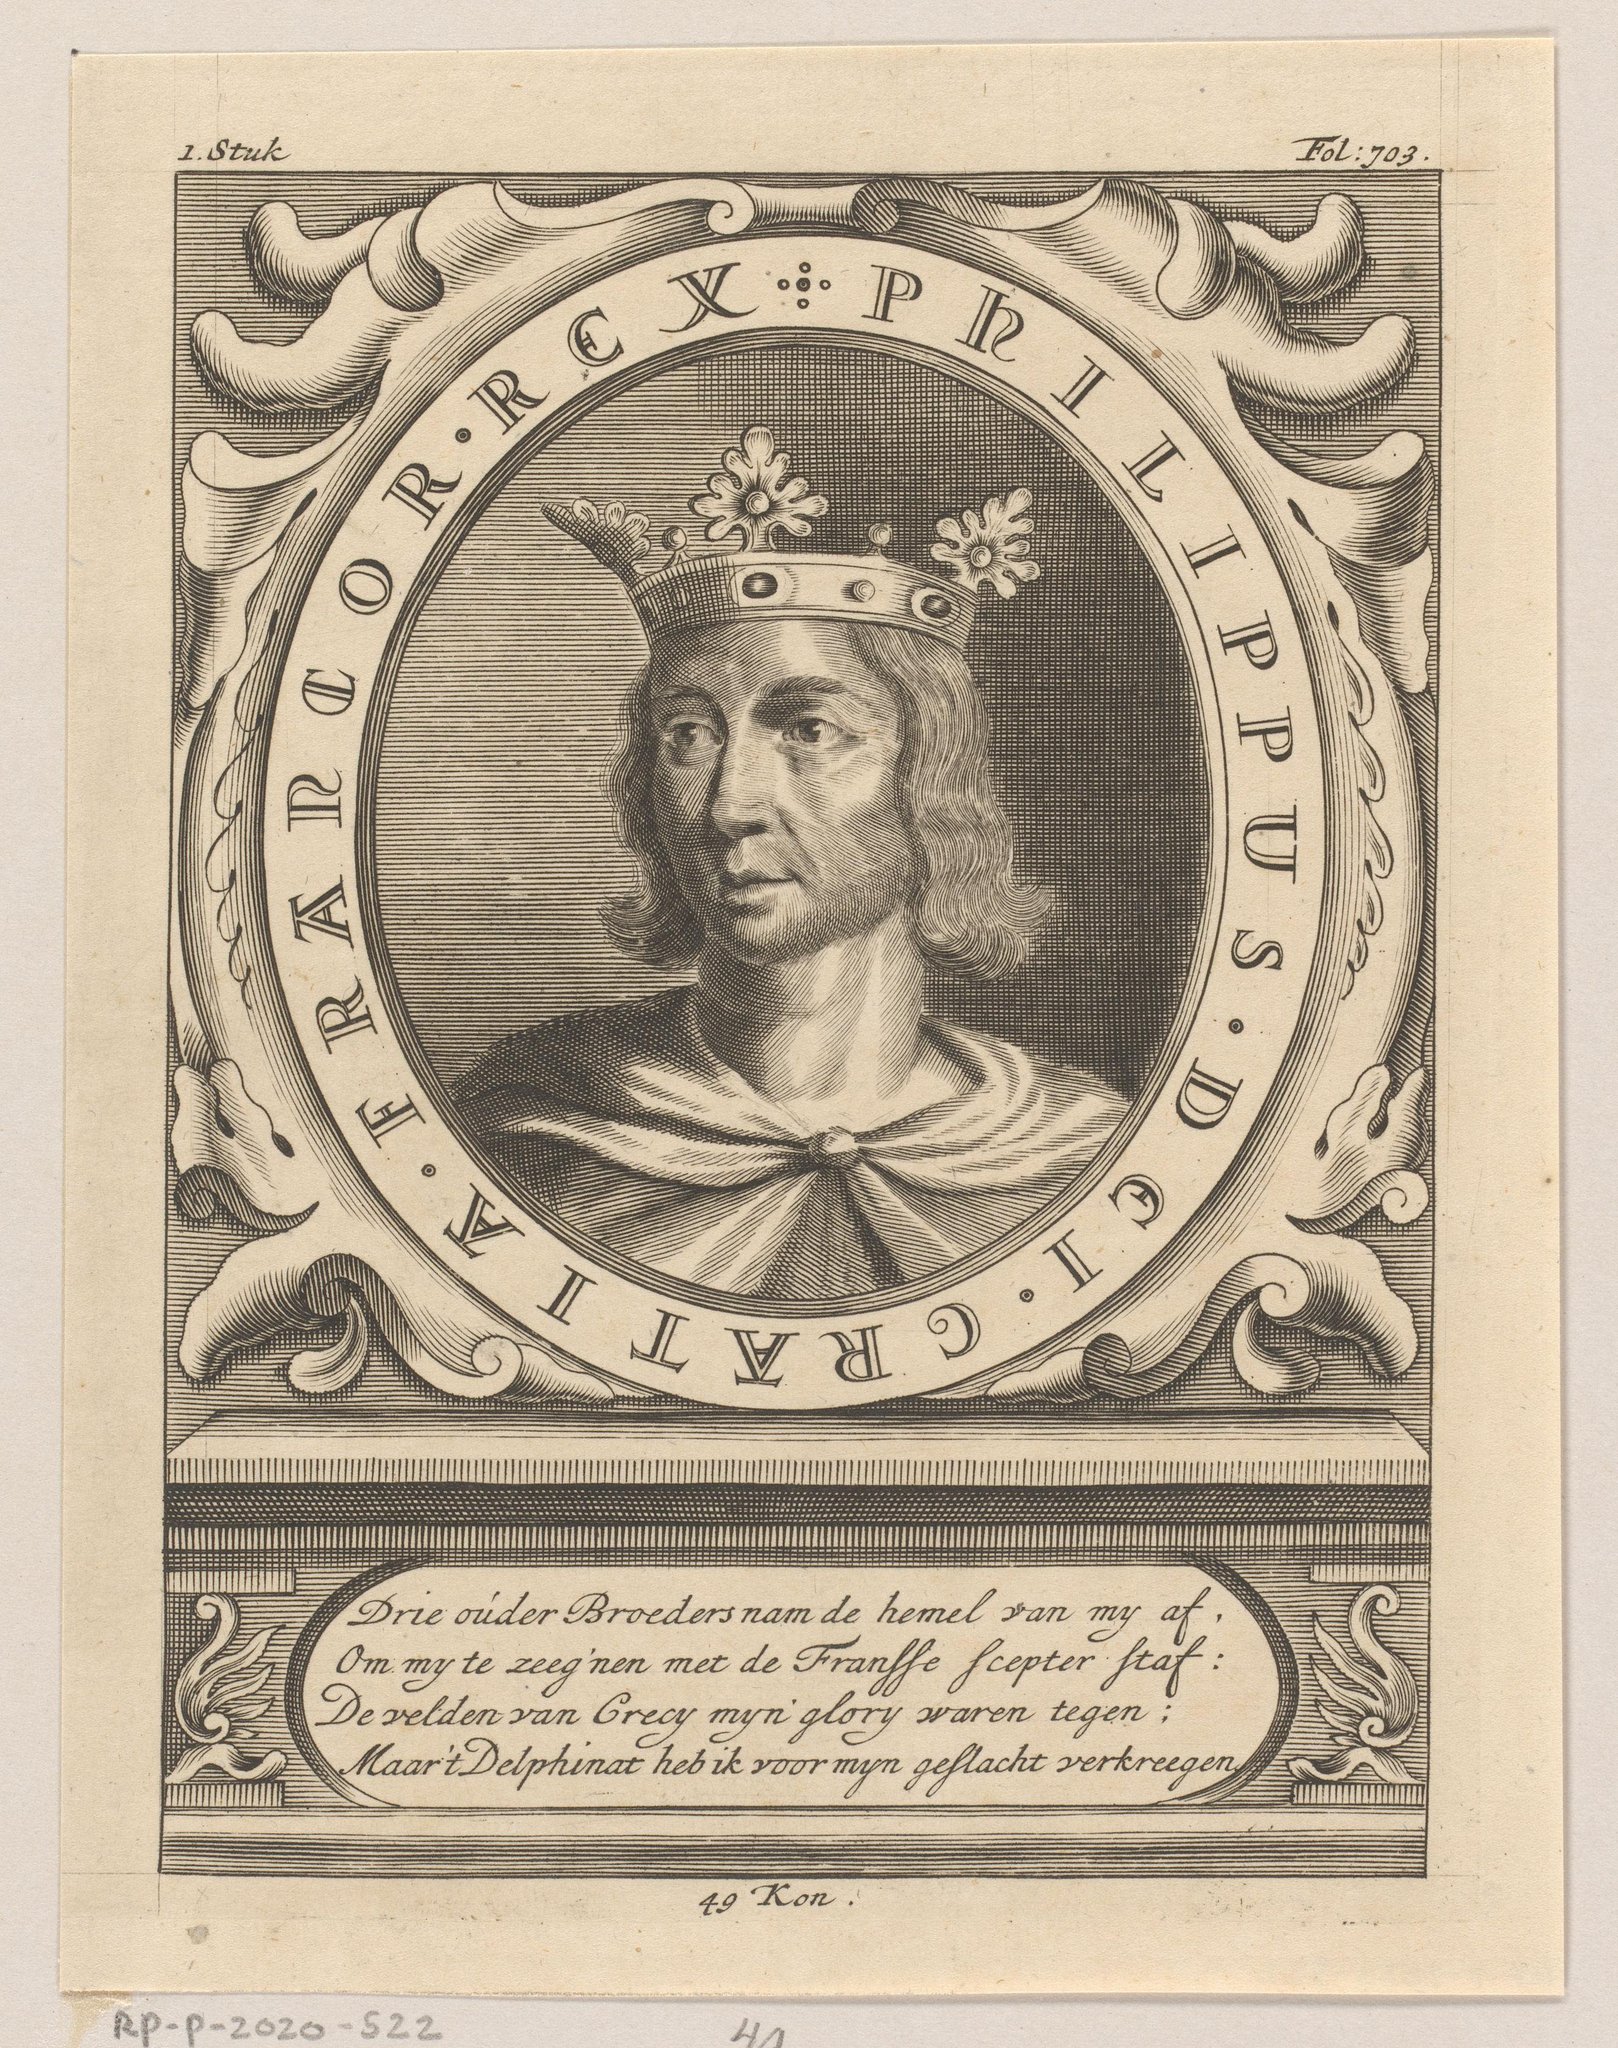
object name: print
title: Portret van Filips VI, koning van Frankrijk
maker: Anonymous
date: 1685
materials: paper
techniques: engraving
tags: historical persons, king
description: Prent gebruikt in: Eudes de Mézeray, François. Chronyk van Vrankryk. 6 dln. Amsterdam: Jan Bouman en Timotheum ten Hoorn, 1685, dl. 3.